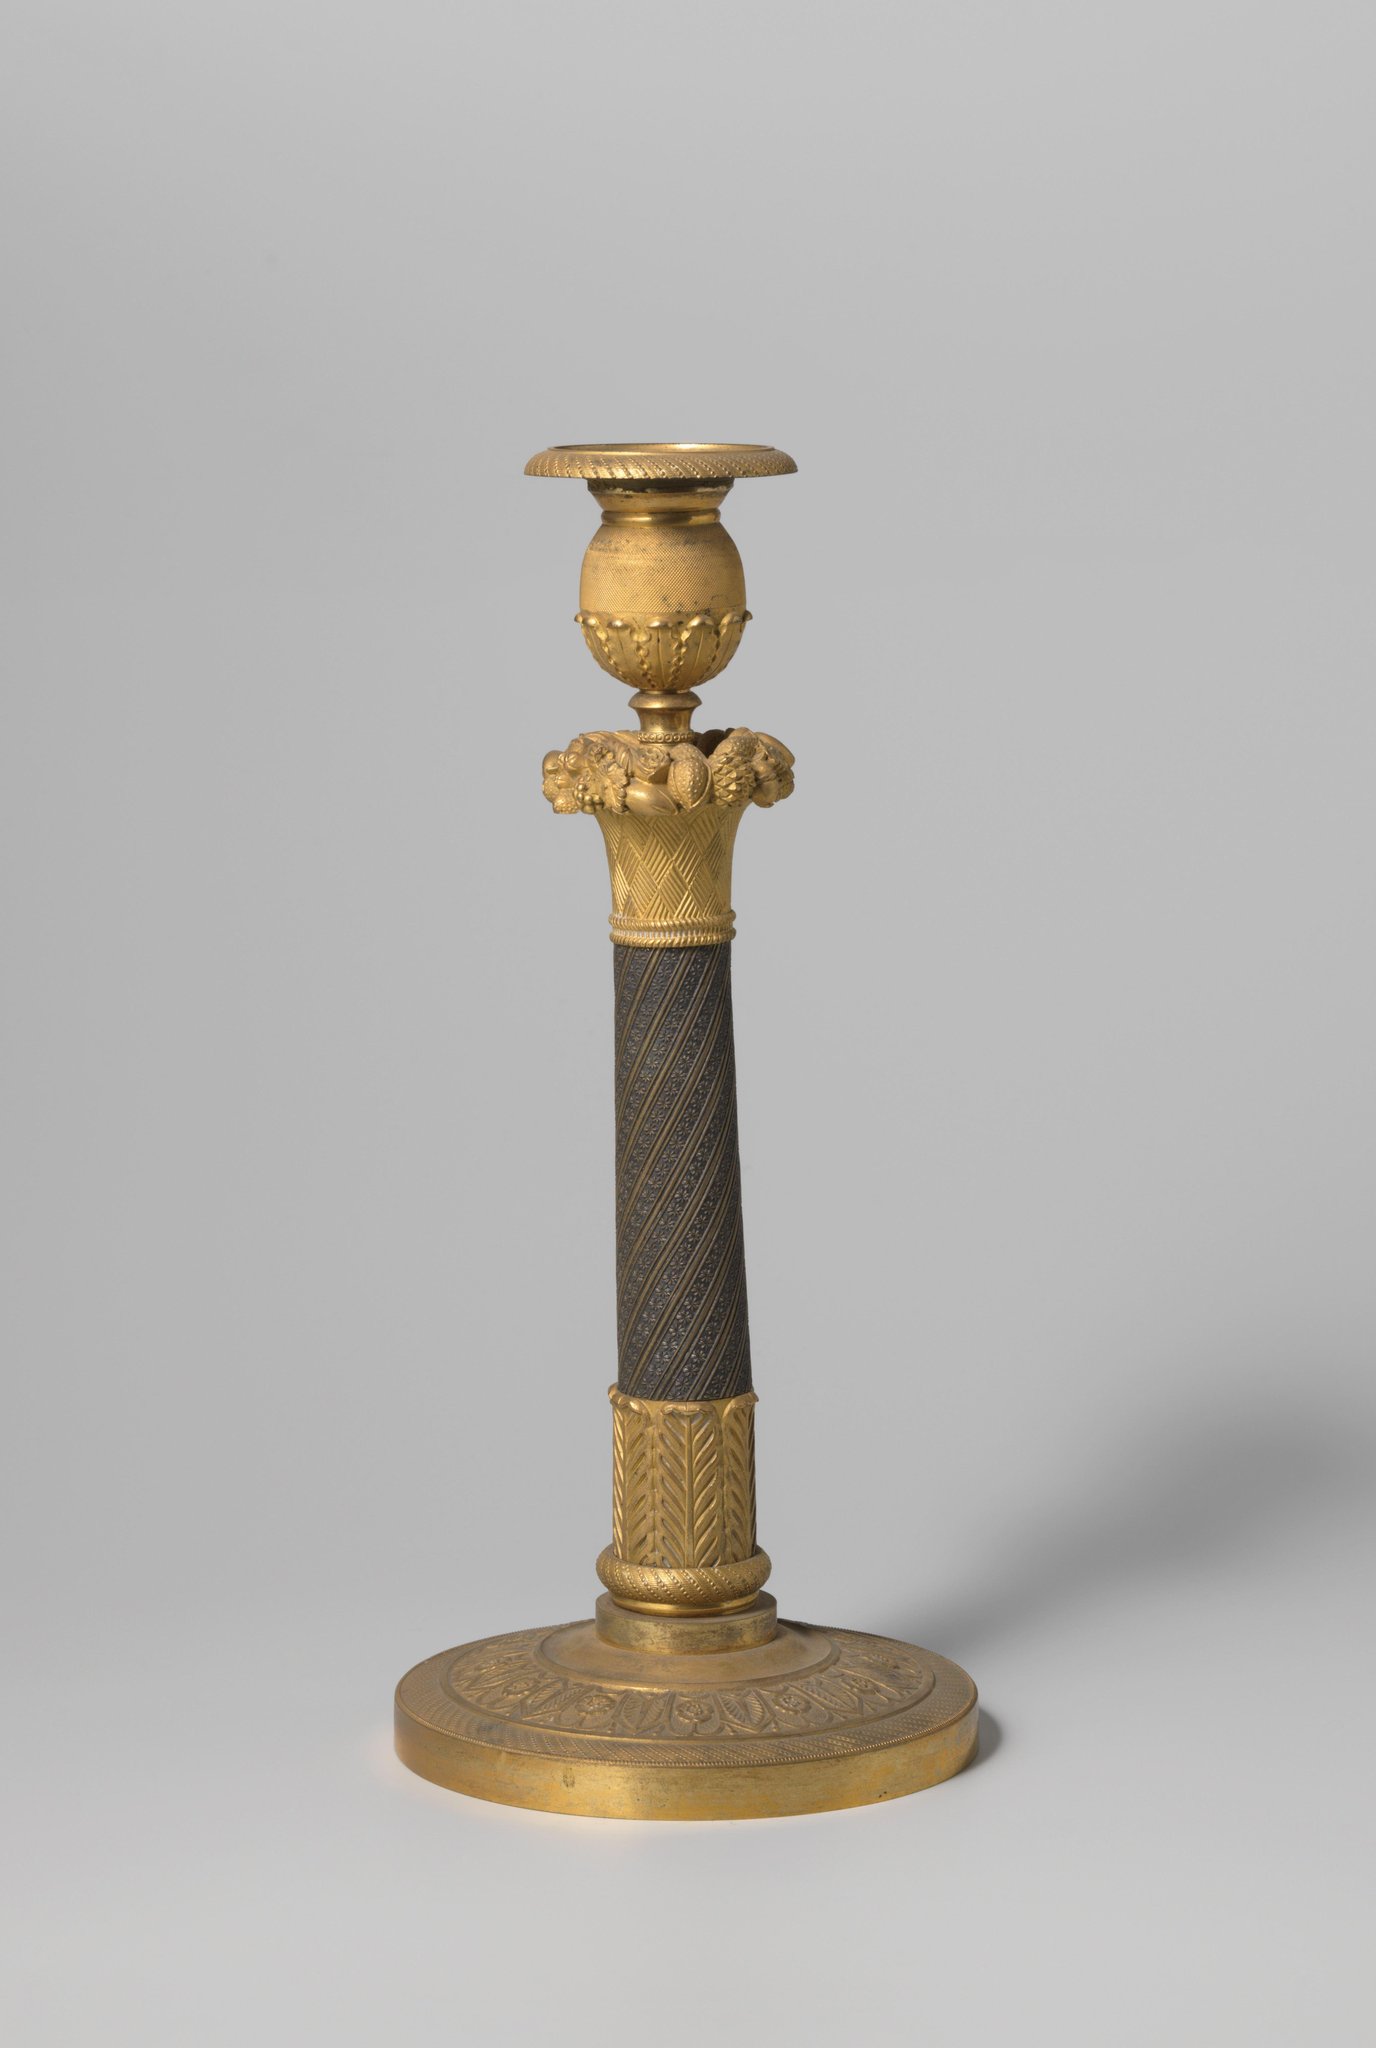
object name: lighting device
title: Kandelaar van gedeeltelijk verguld brons, versierd met rozetten en bekroond door een mand met bloemen en vruchten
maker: Anonymous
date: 1830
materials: wood, bronze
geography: france